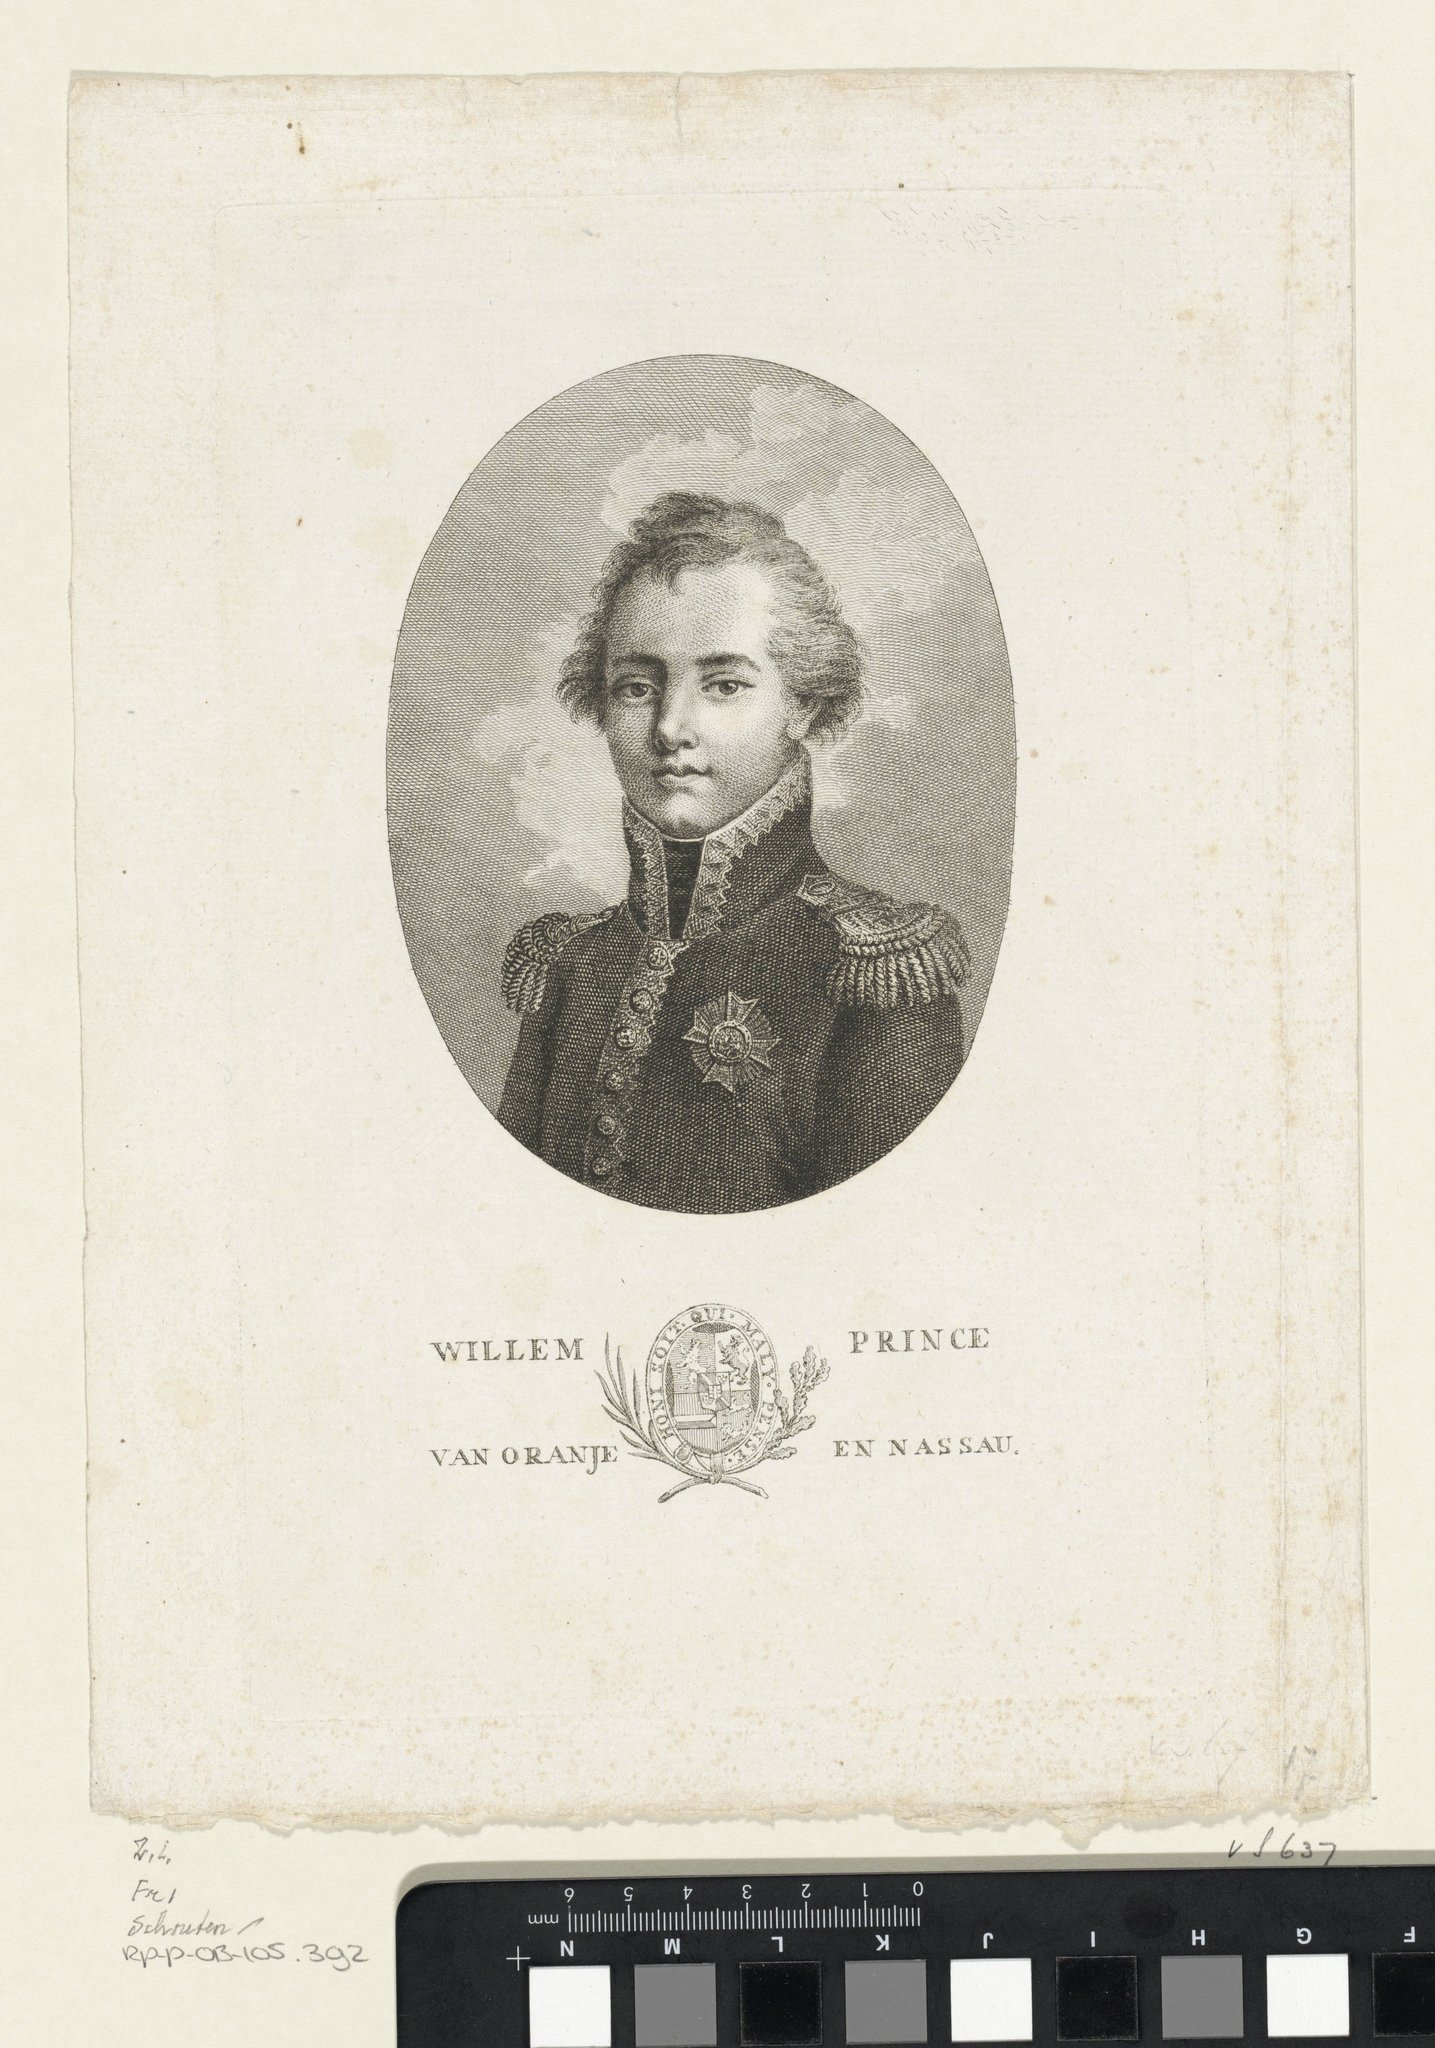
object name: print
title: Portret van Willem II, koning der Nederlanden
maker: Anonymous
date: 1805-1899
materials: paper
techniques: engraving, etching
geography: low countries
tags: the hague, william ii of the netherlands, knighthood order (garter) - insignia of a knighthood order, e.g.: badge, chain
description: Portret van Willem II in een ovaal. Midden onder zijn wapen, gedecoreerd met de Kousenband en het devies van de Orde van de Kousenband. In de ondermarge zijn naam en titel.